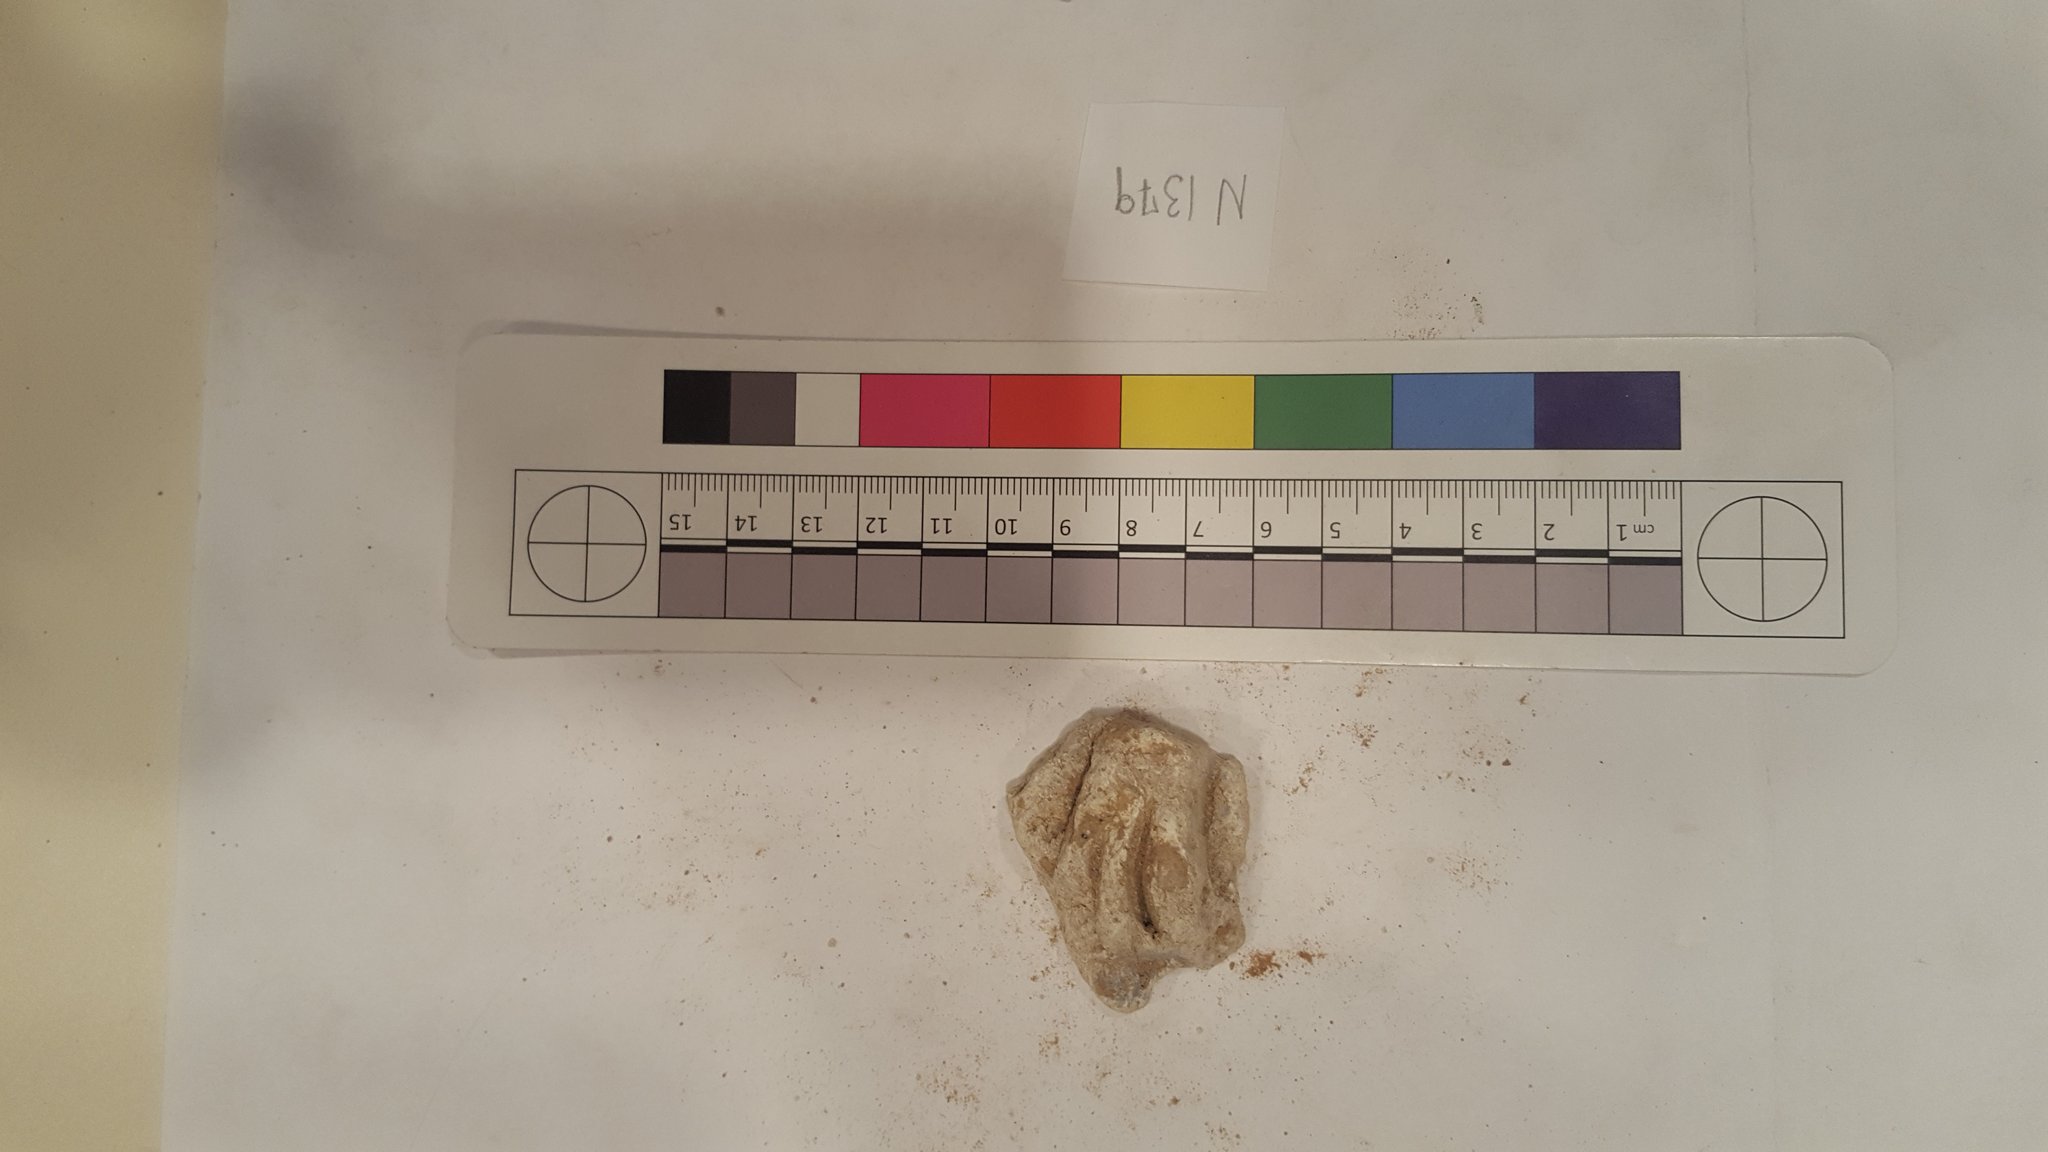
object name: fragment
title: Stucco Fragment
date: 701-1200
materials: plaster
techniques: carving, painting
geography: iran